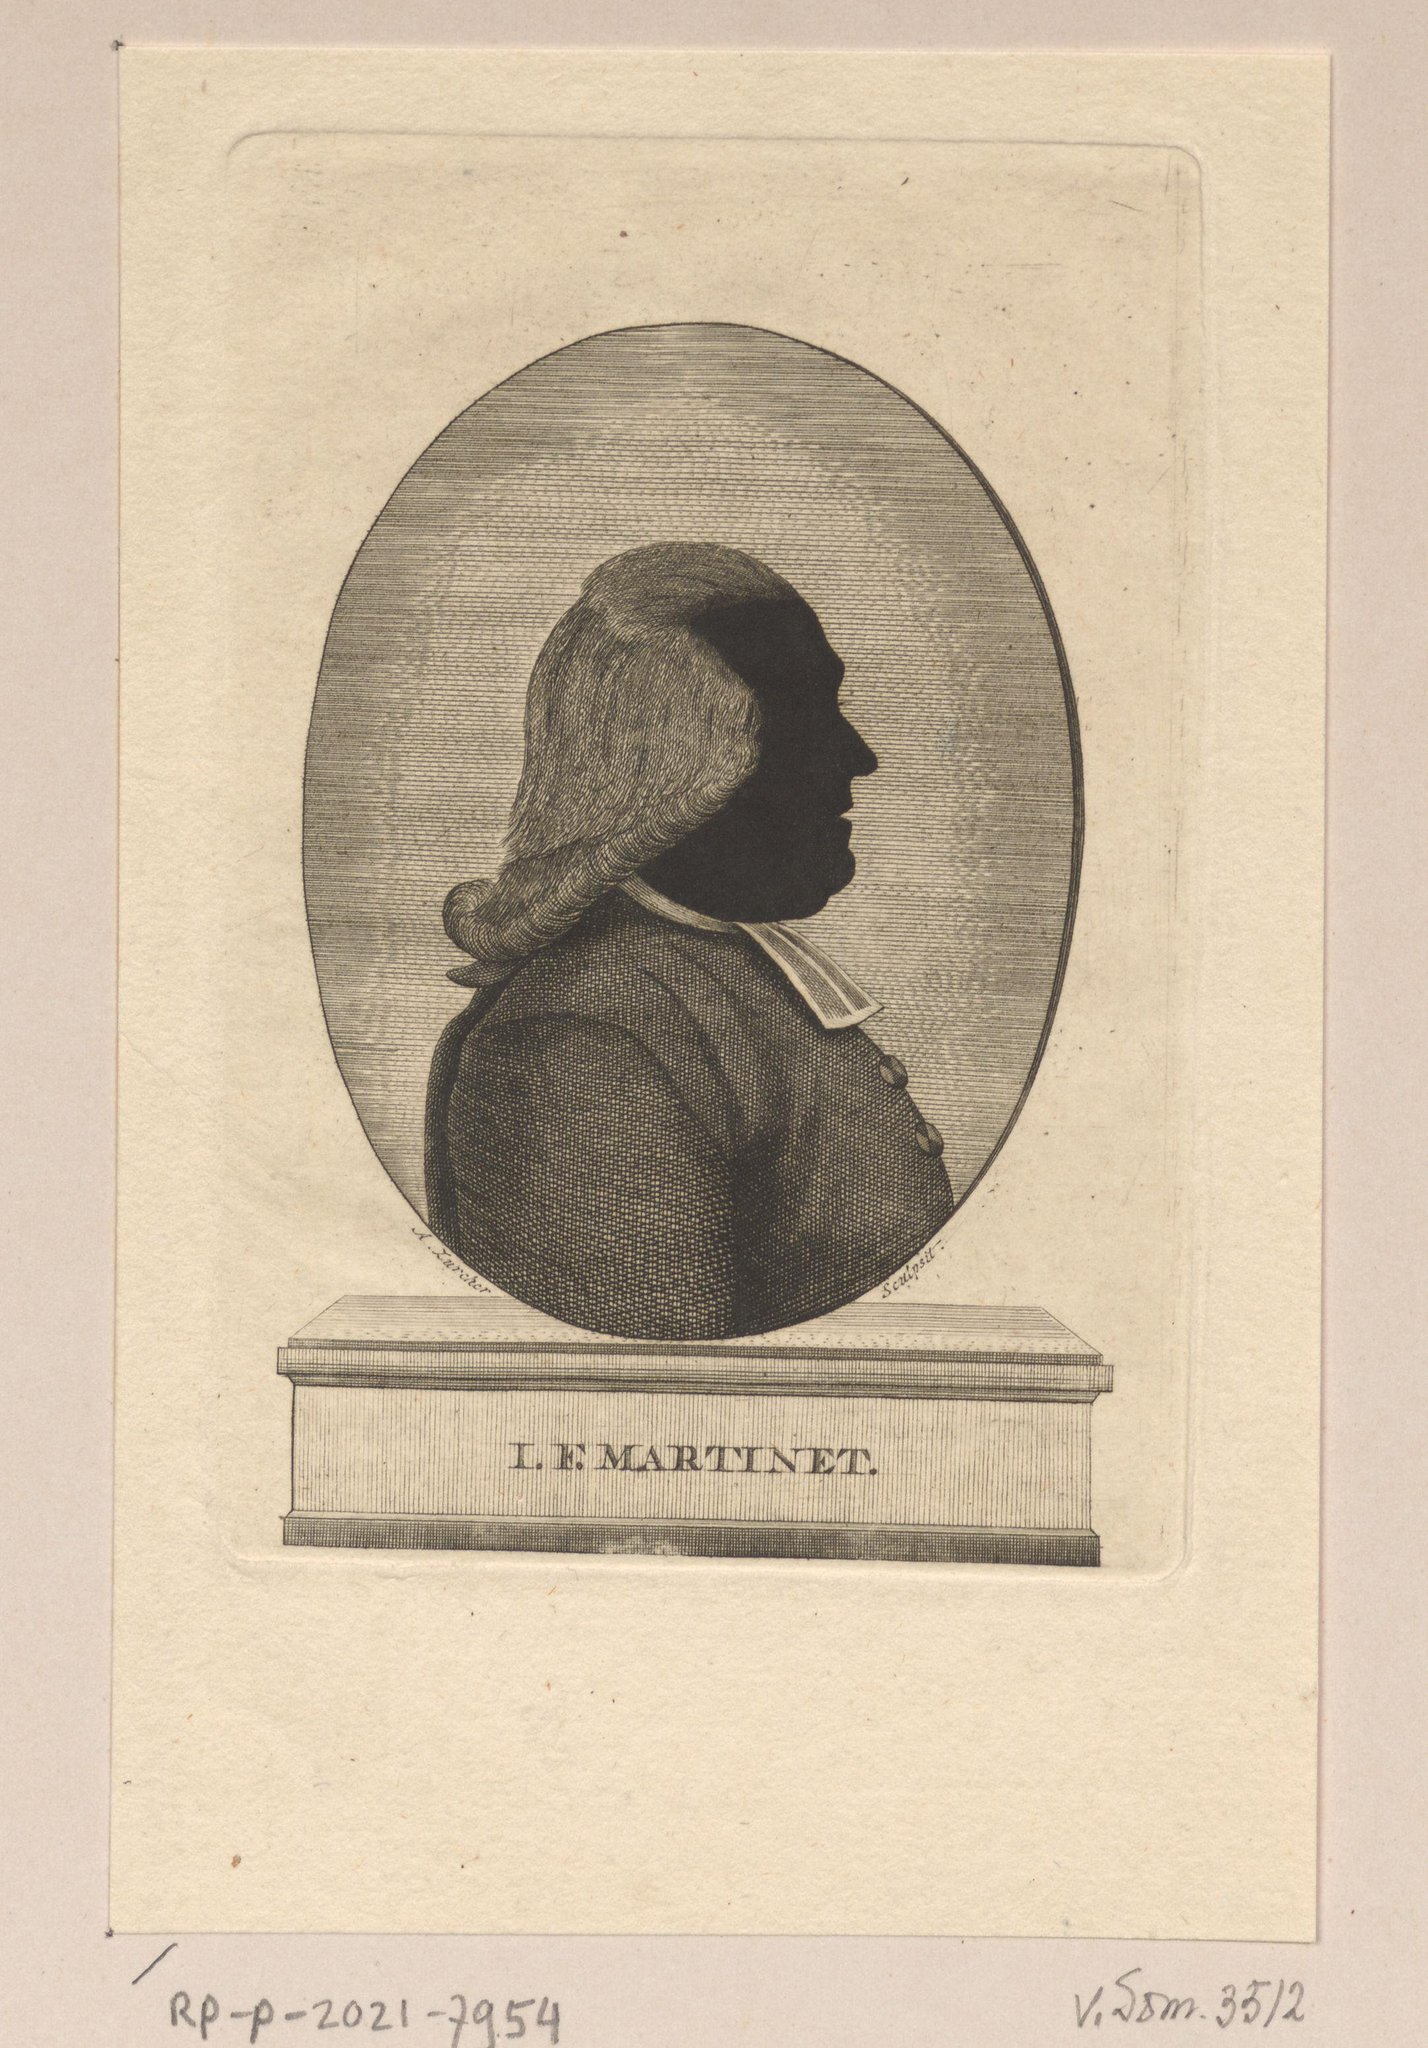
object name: print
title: Silhouetportret van Joannes Florentius Martinet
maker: antoni zürcher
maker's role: print maker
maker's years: 1754-1837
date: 1770-1837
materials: paper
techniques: engraving, etching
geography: amsterdam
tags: joannes florentius martinet, ornament ~ medallion, historical persons, portrait of a writer